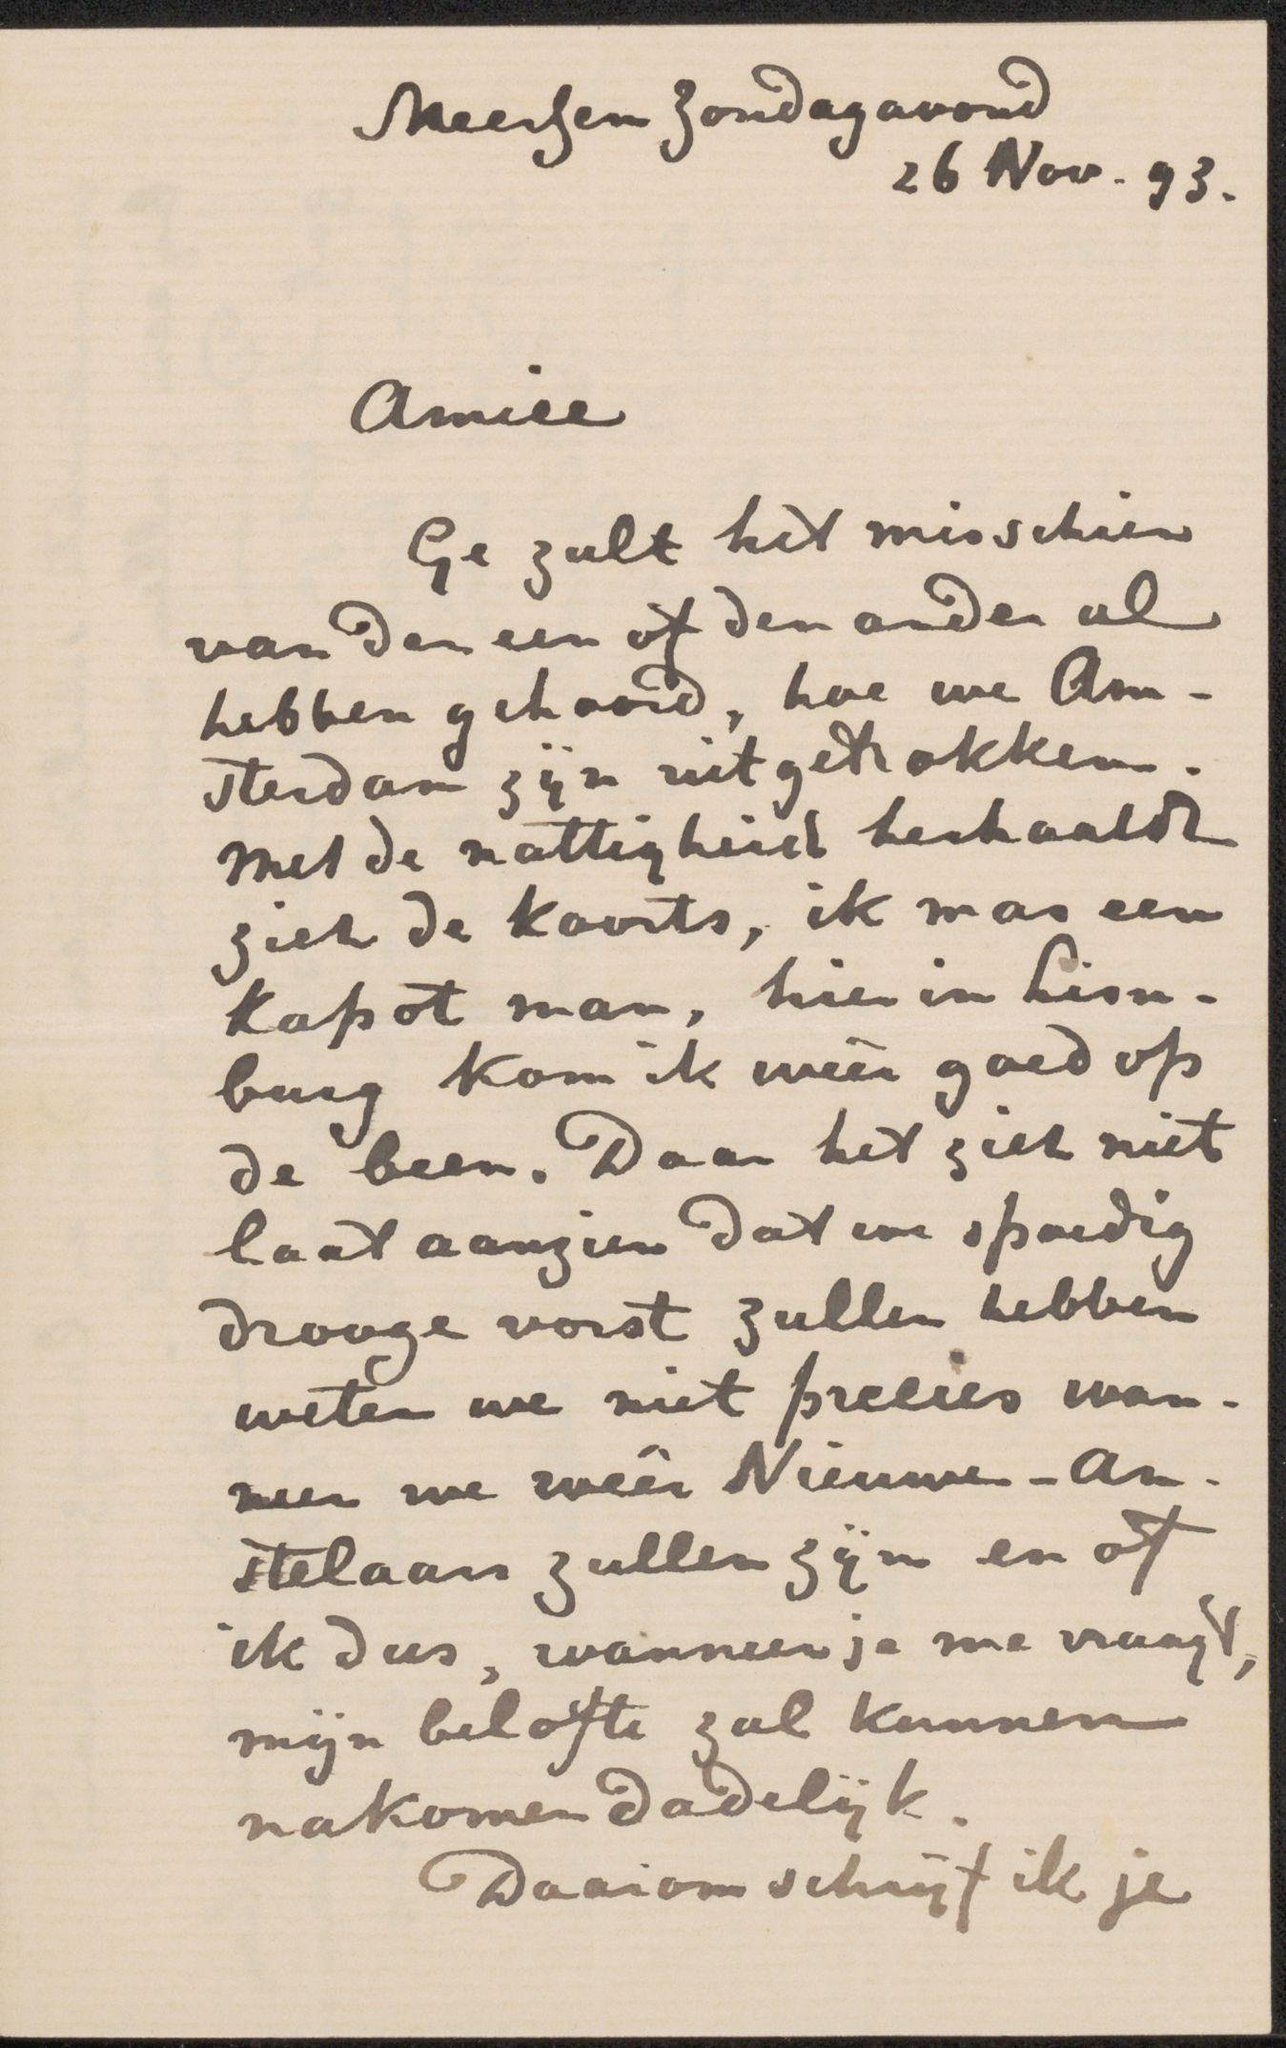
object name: letter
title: Brief aan Jan Veth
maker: jac van looij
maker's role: draughtsman, painter, print maker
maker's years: 1855-1930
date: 1893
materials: ink, paper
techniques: pen, writing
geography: limburg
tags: jan veth, painting (including book-illumination, miniature-painting), workshop, studio of the artist (in general), amsterdam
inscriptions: collector's mark: ‘RPK’